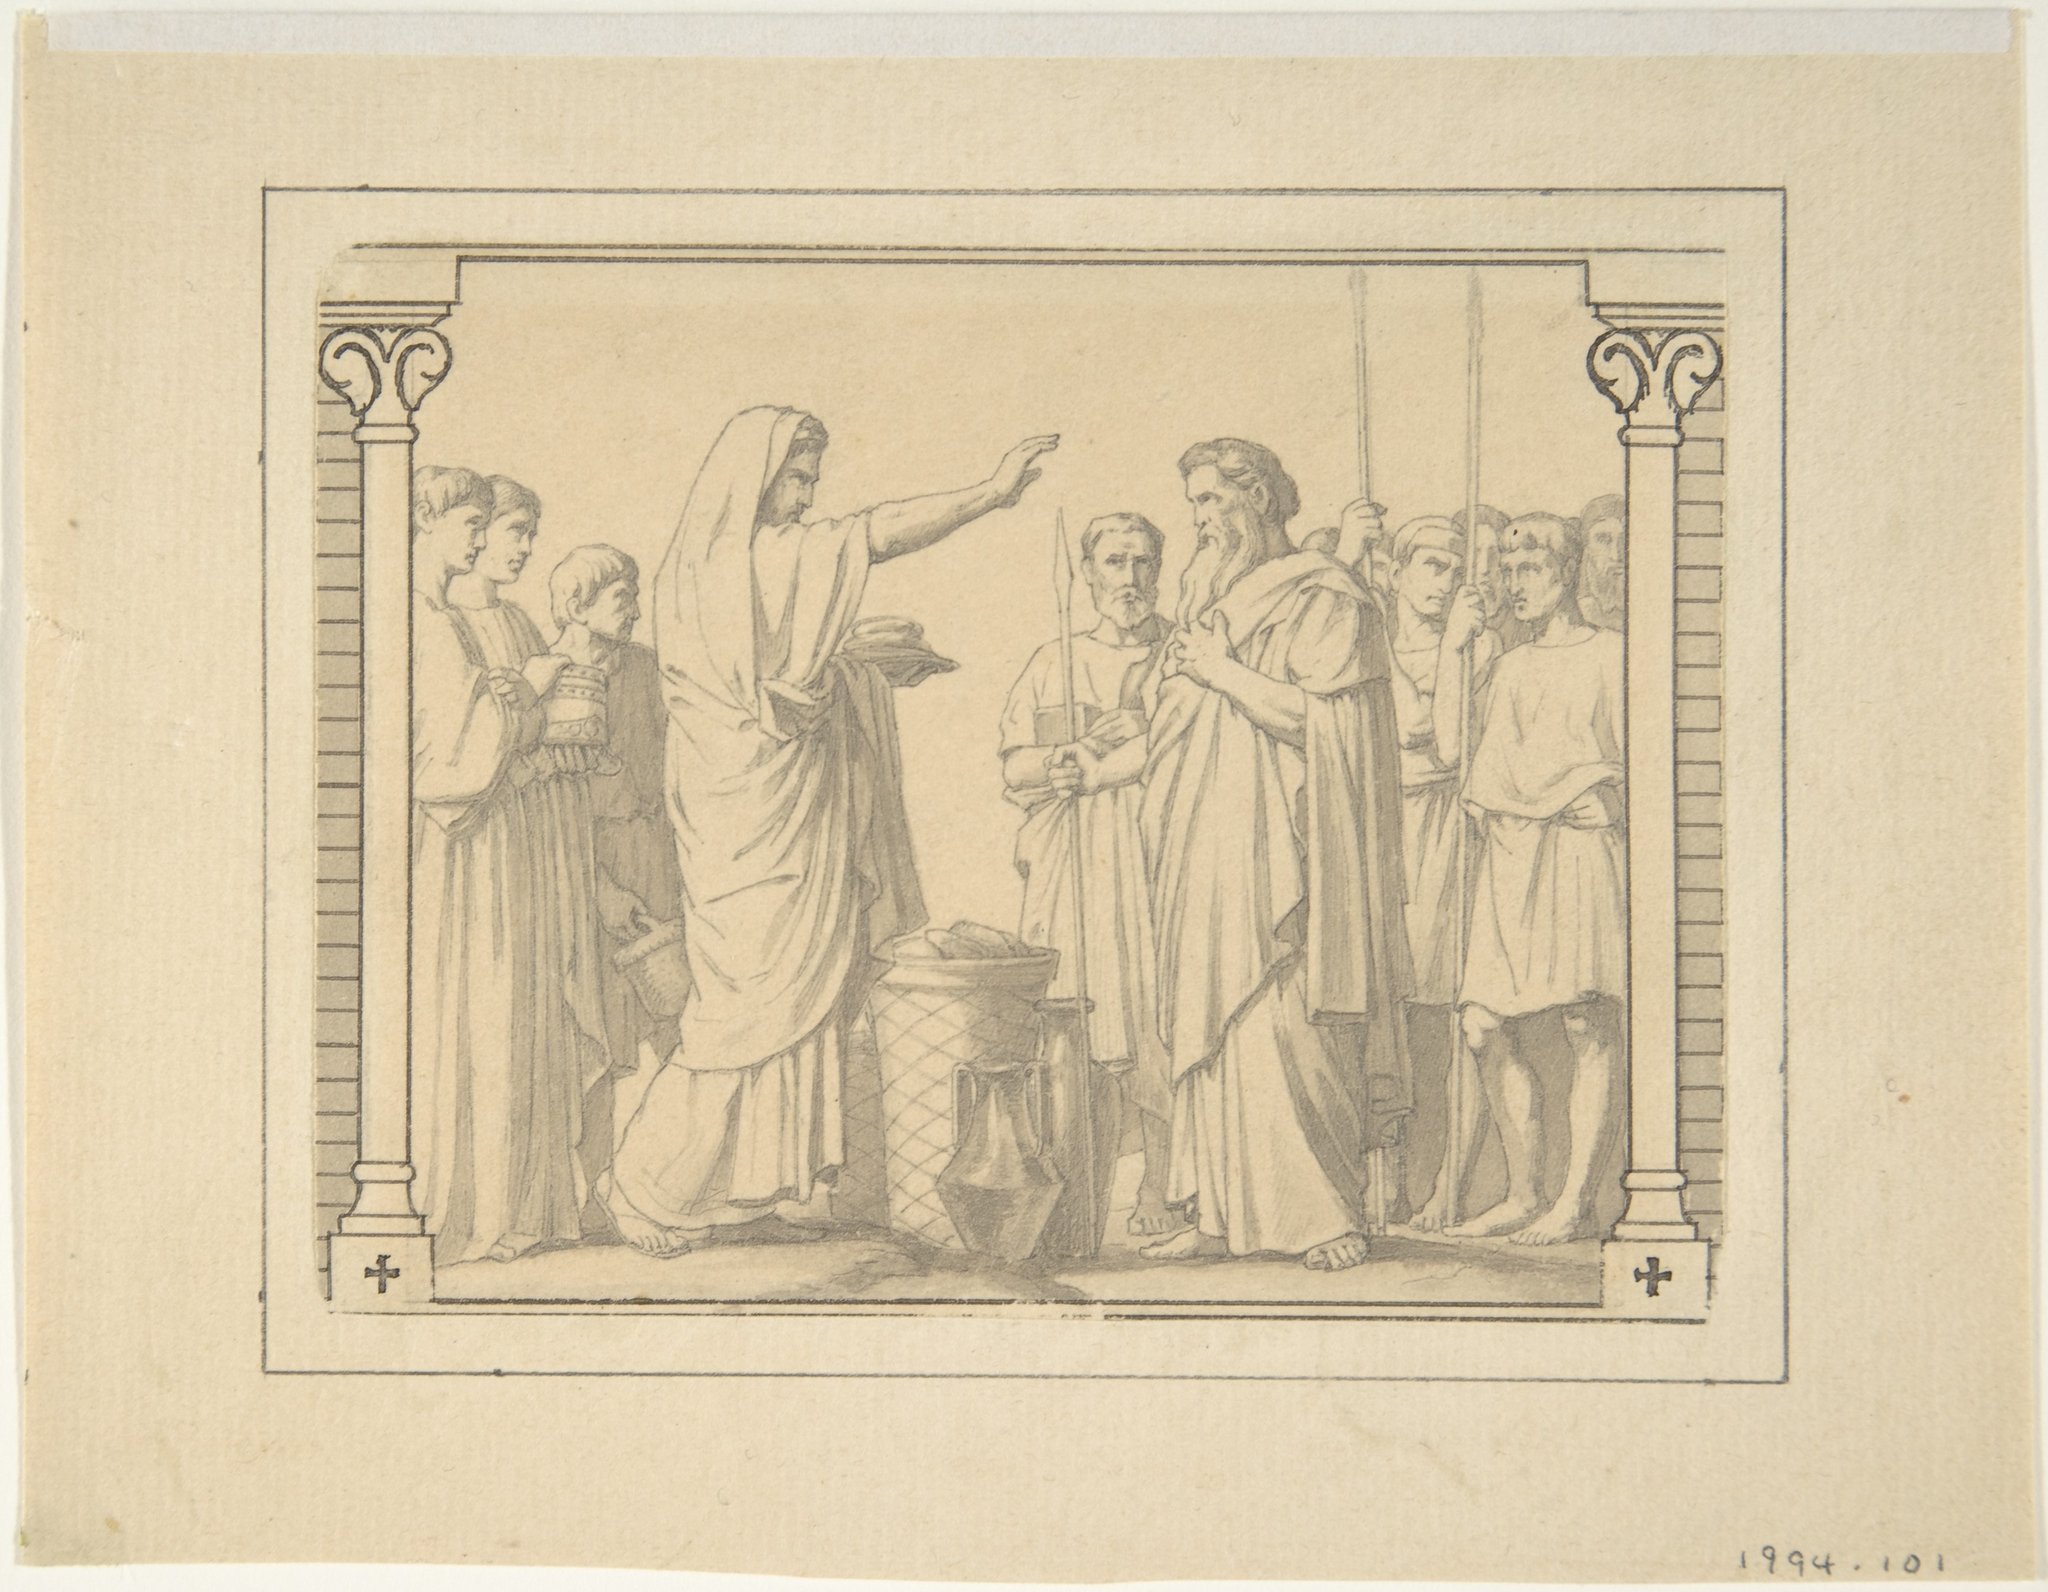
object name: drawing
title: Melchizedek Presenting Abraham with Bread and Wine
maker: hippolyte flandrin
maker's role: artist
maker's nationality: french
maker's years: 1809-1864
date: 1835-1864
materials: graphite, ink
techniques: pen, wash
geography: france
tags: spears,bread,wine,men,abraham